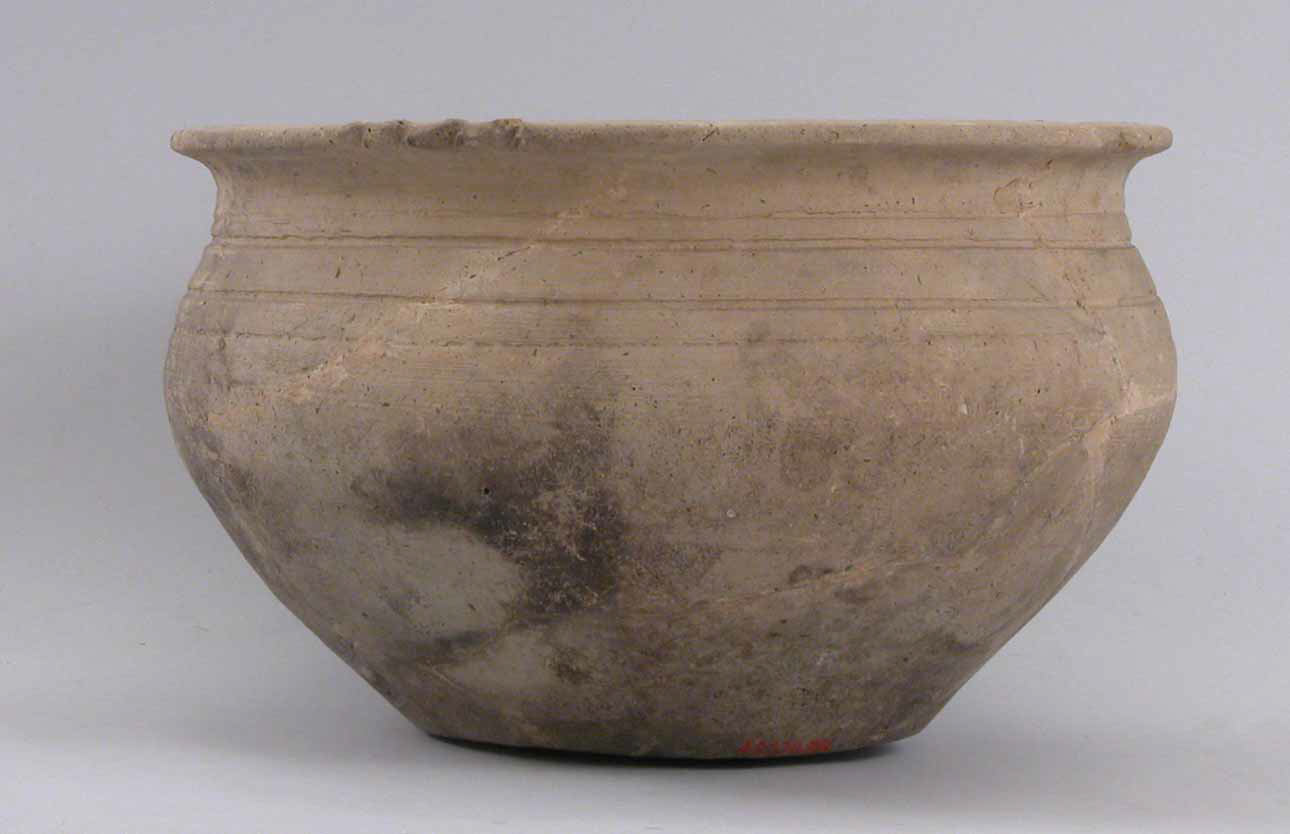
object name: bowl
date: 801-1000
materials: earthenware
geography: iran